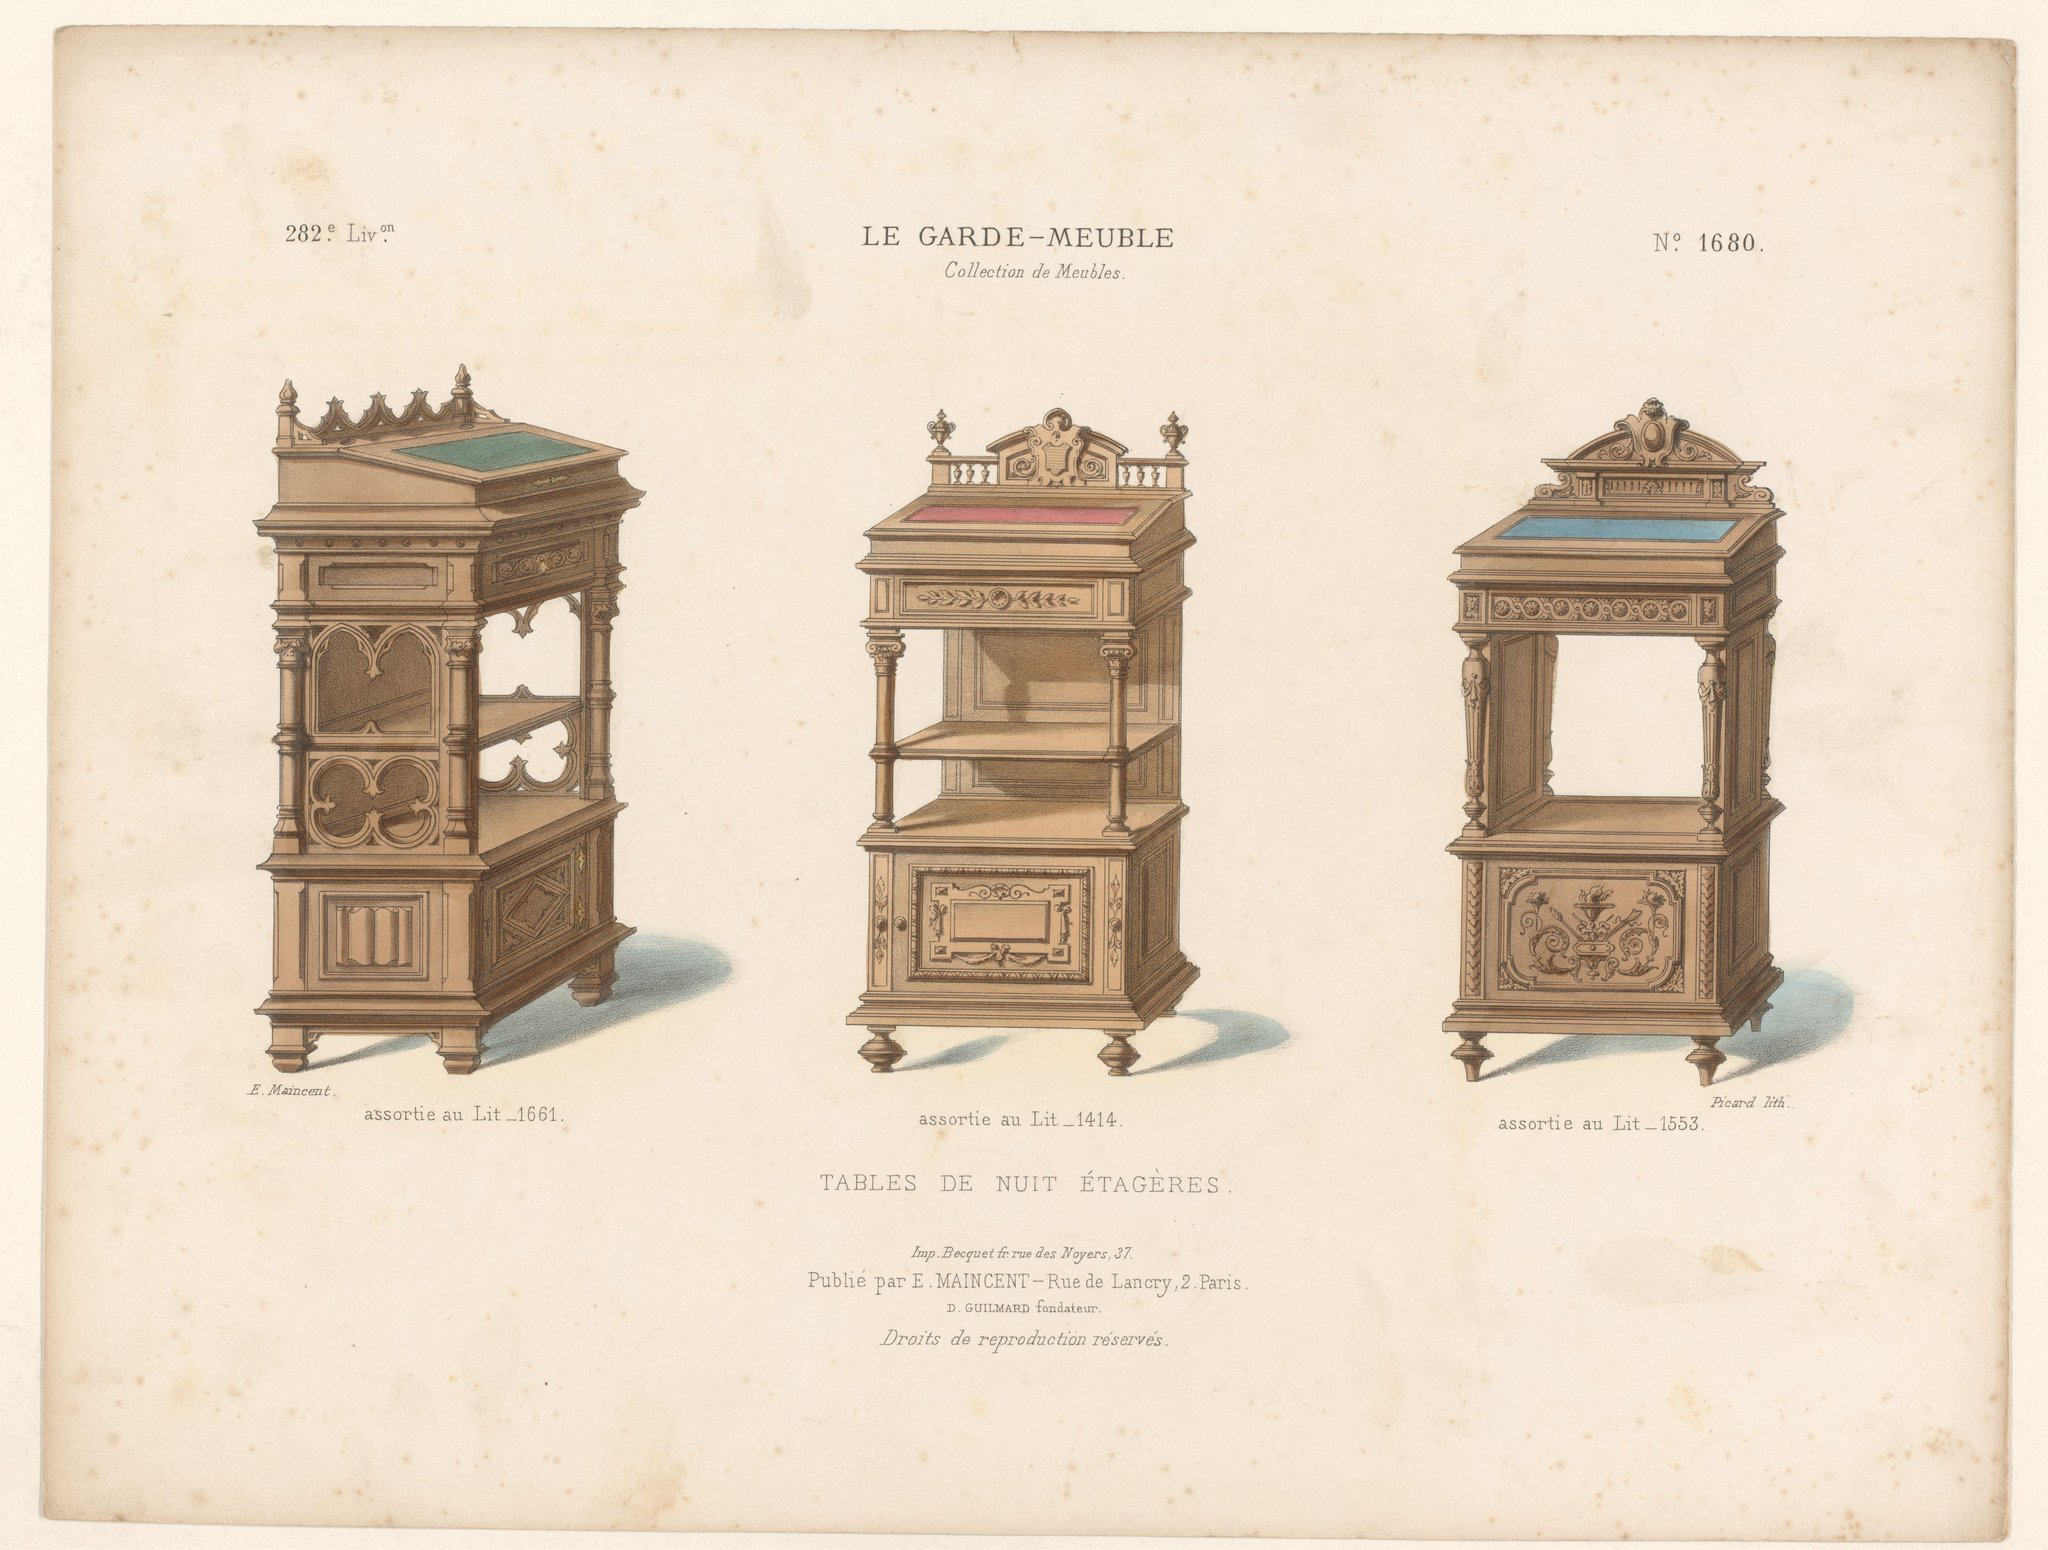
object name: print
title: Le garde-meuble / Collection de Meubles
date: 1885-1895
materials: paper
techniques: hand coloring, lithograph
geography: paris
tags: furniture for storage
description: Ieder Livraison in de serie Le Garde-Meuble bevat negen platen: drie 'sièges' (zitmeubels), drie 'meubles' (diverse meubels zoals tafels en kasten) en drie 'tentures' (gordijnen en draperieën).